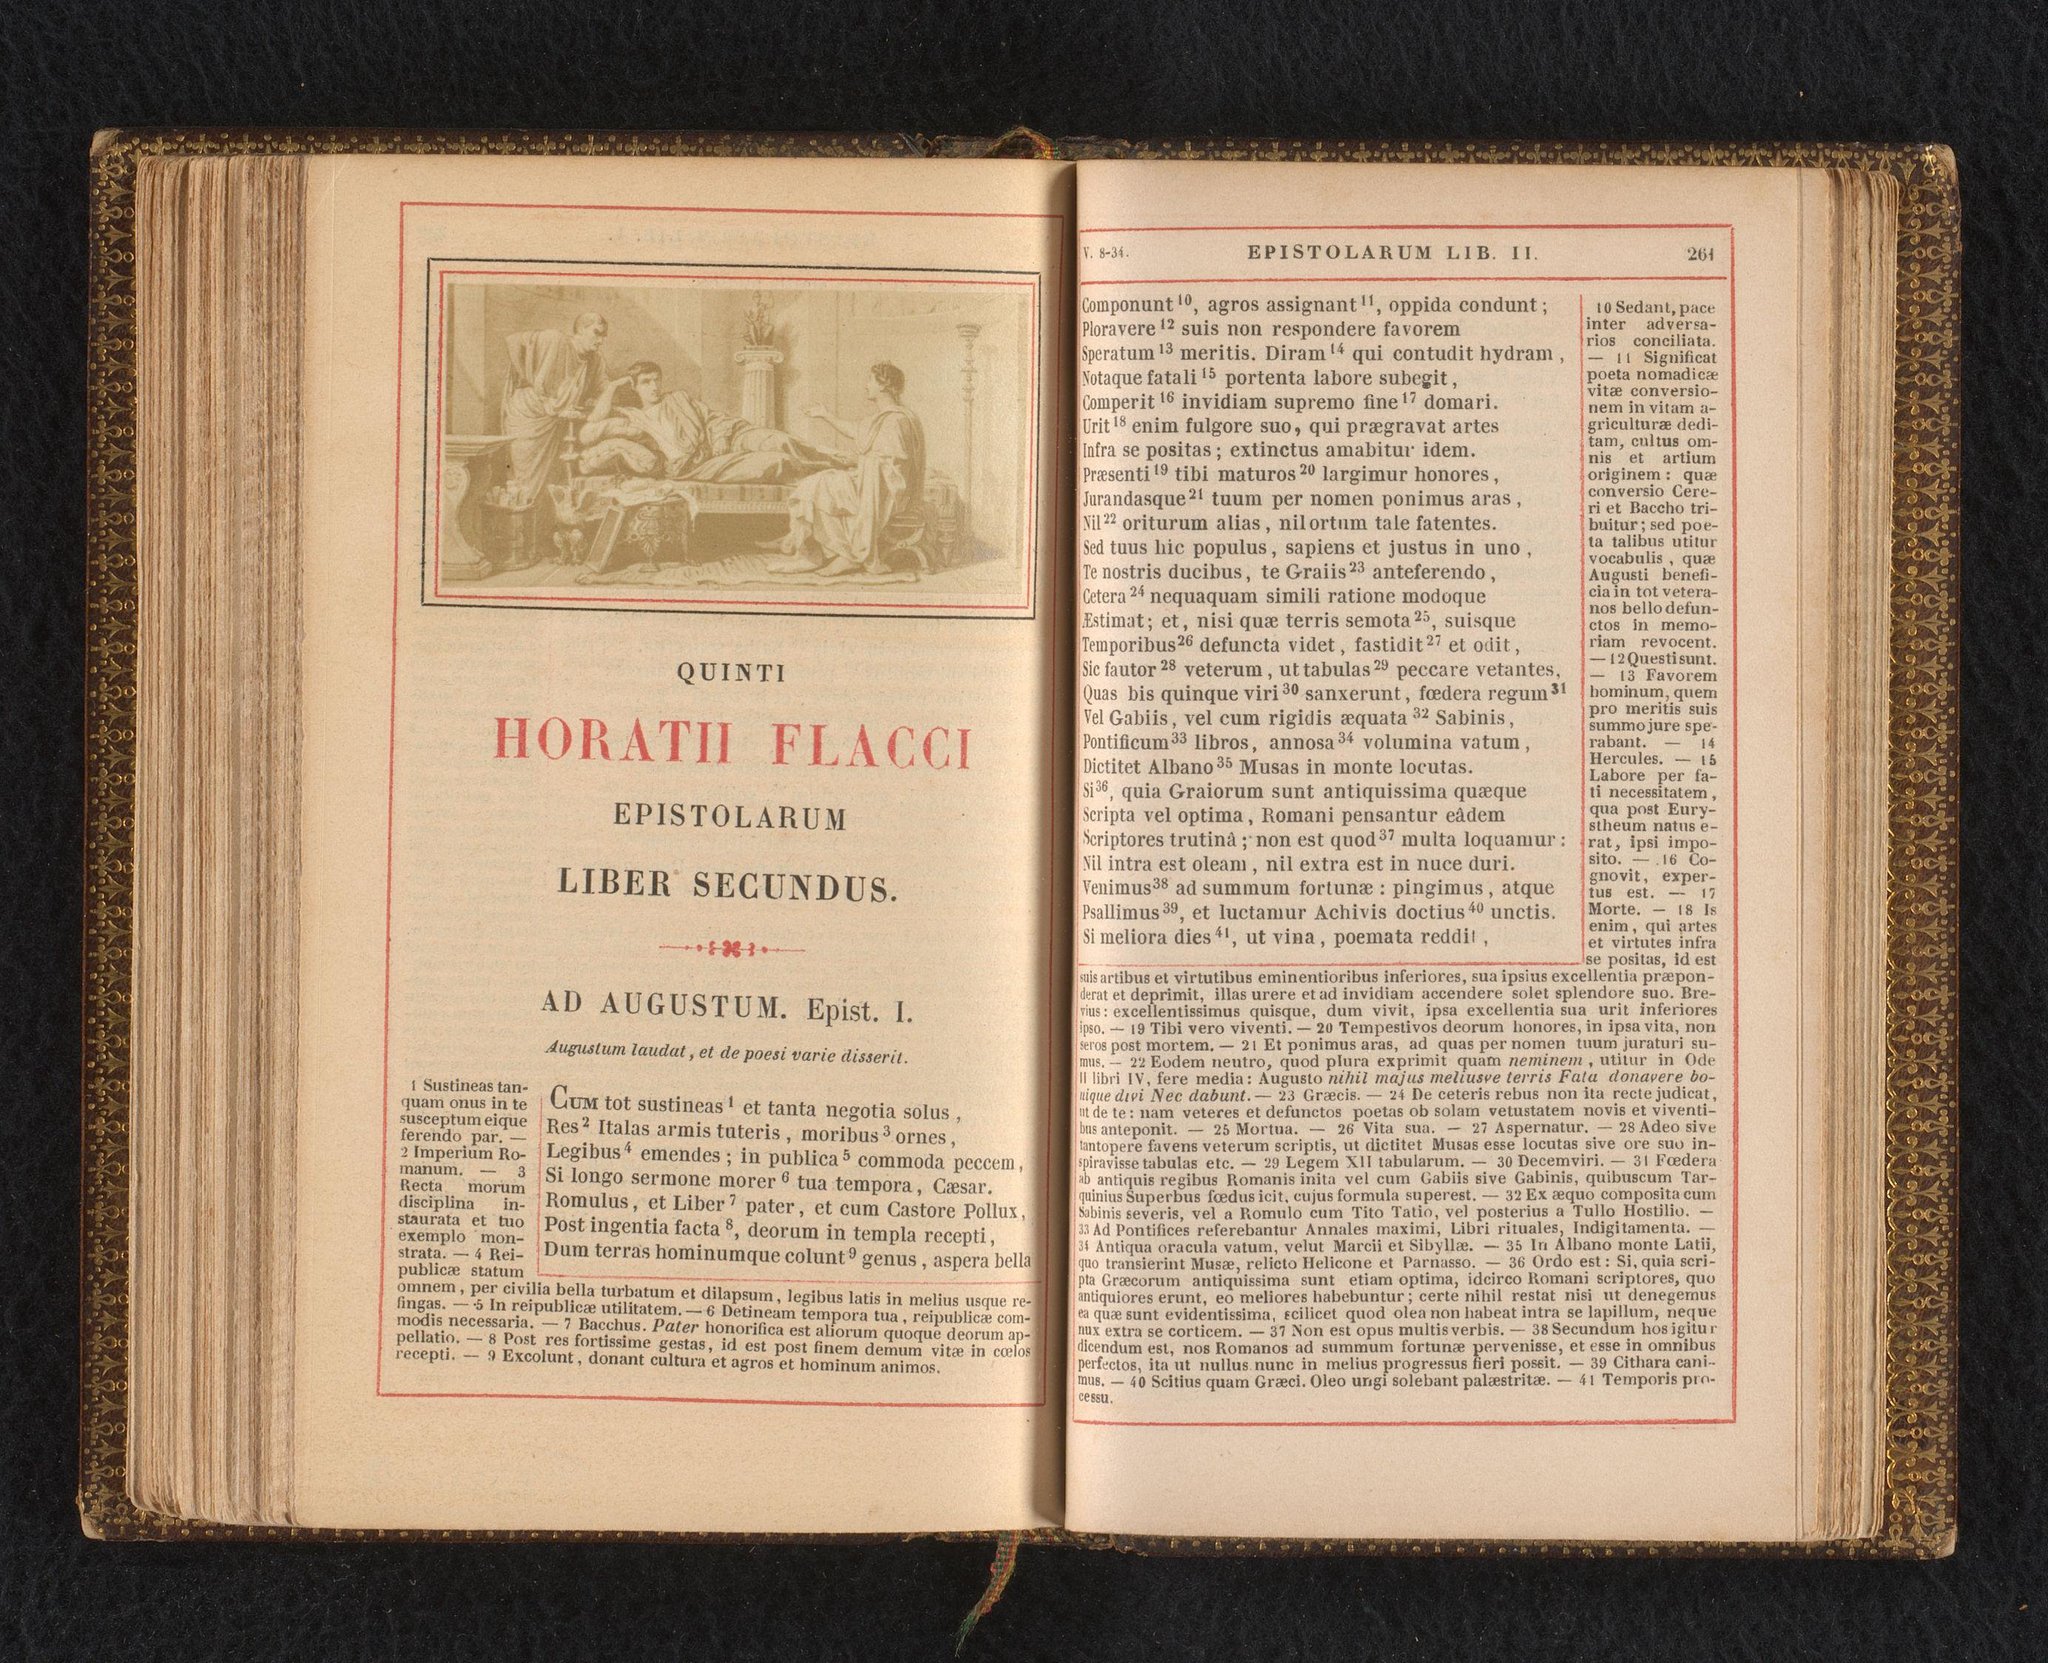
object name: reproduction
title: Fotoreproductie van een illustratie van drie mannen bij een ligbed in een interieur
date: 1851-1855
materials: paper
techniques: albumen print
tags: debate, discussion (~ meeting), couch, sofa, settee